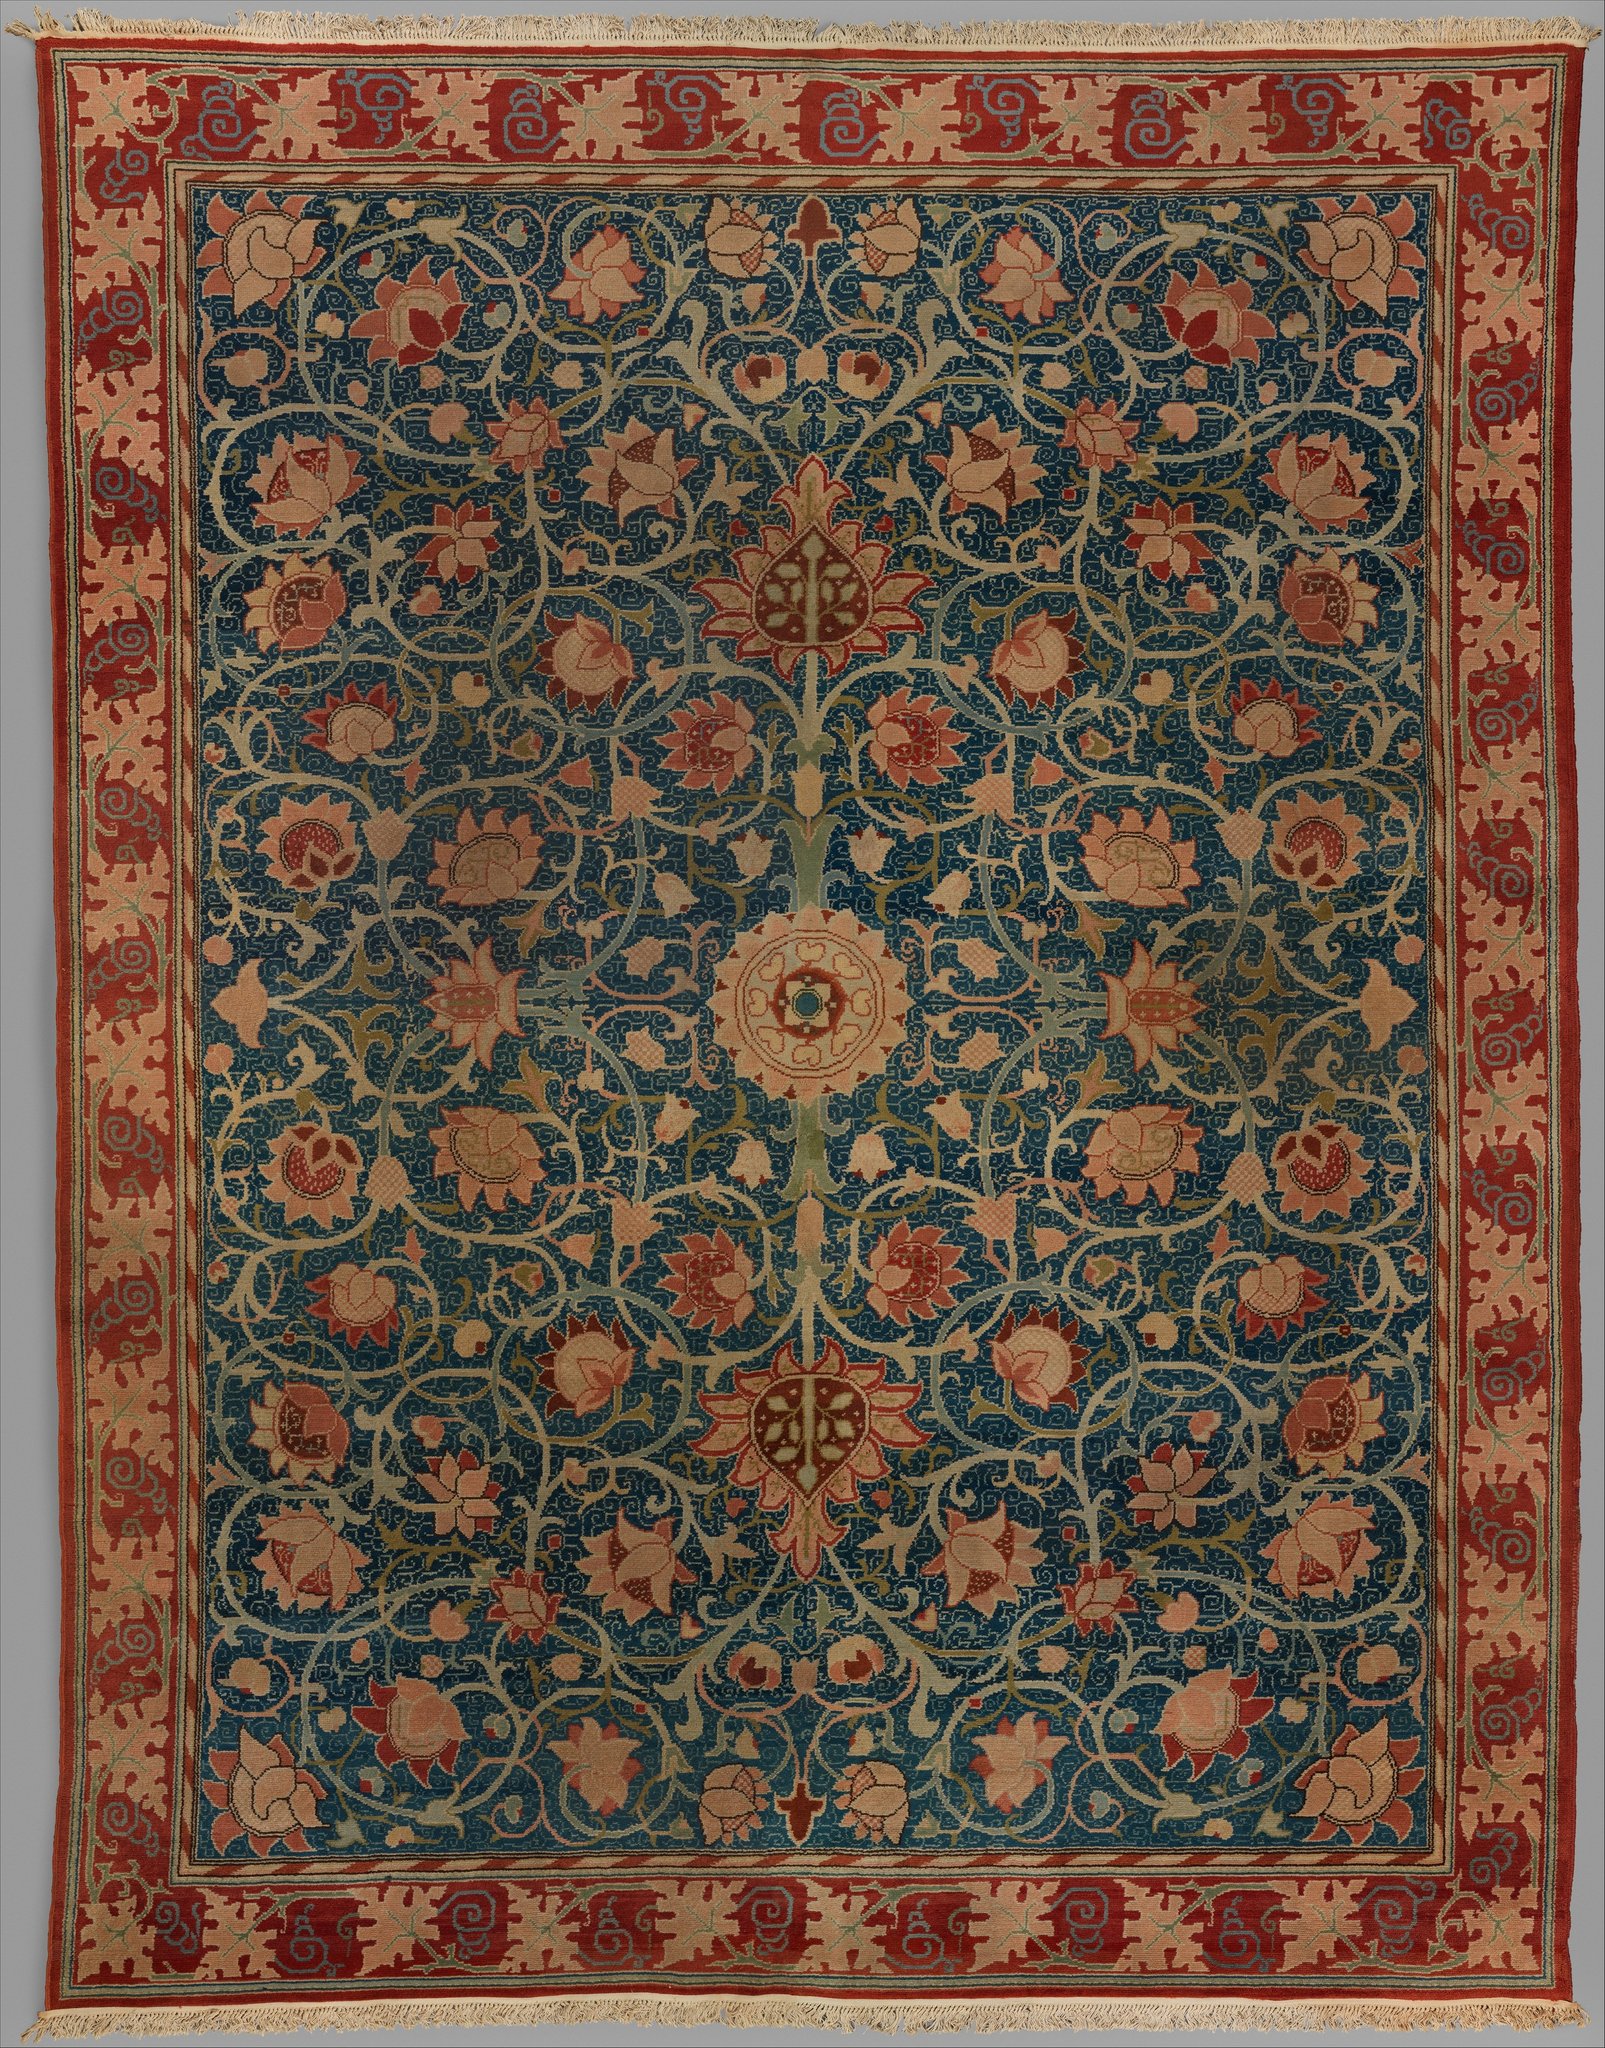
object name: carpet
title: Holland Park carpet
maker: william morris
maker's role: designer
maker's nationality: british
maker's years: 1834-1896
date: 1867-1900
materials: wool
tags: flowers